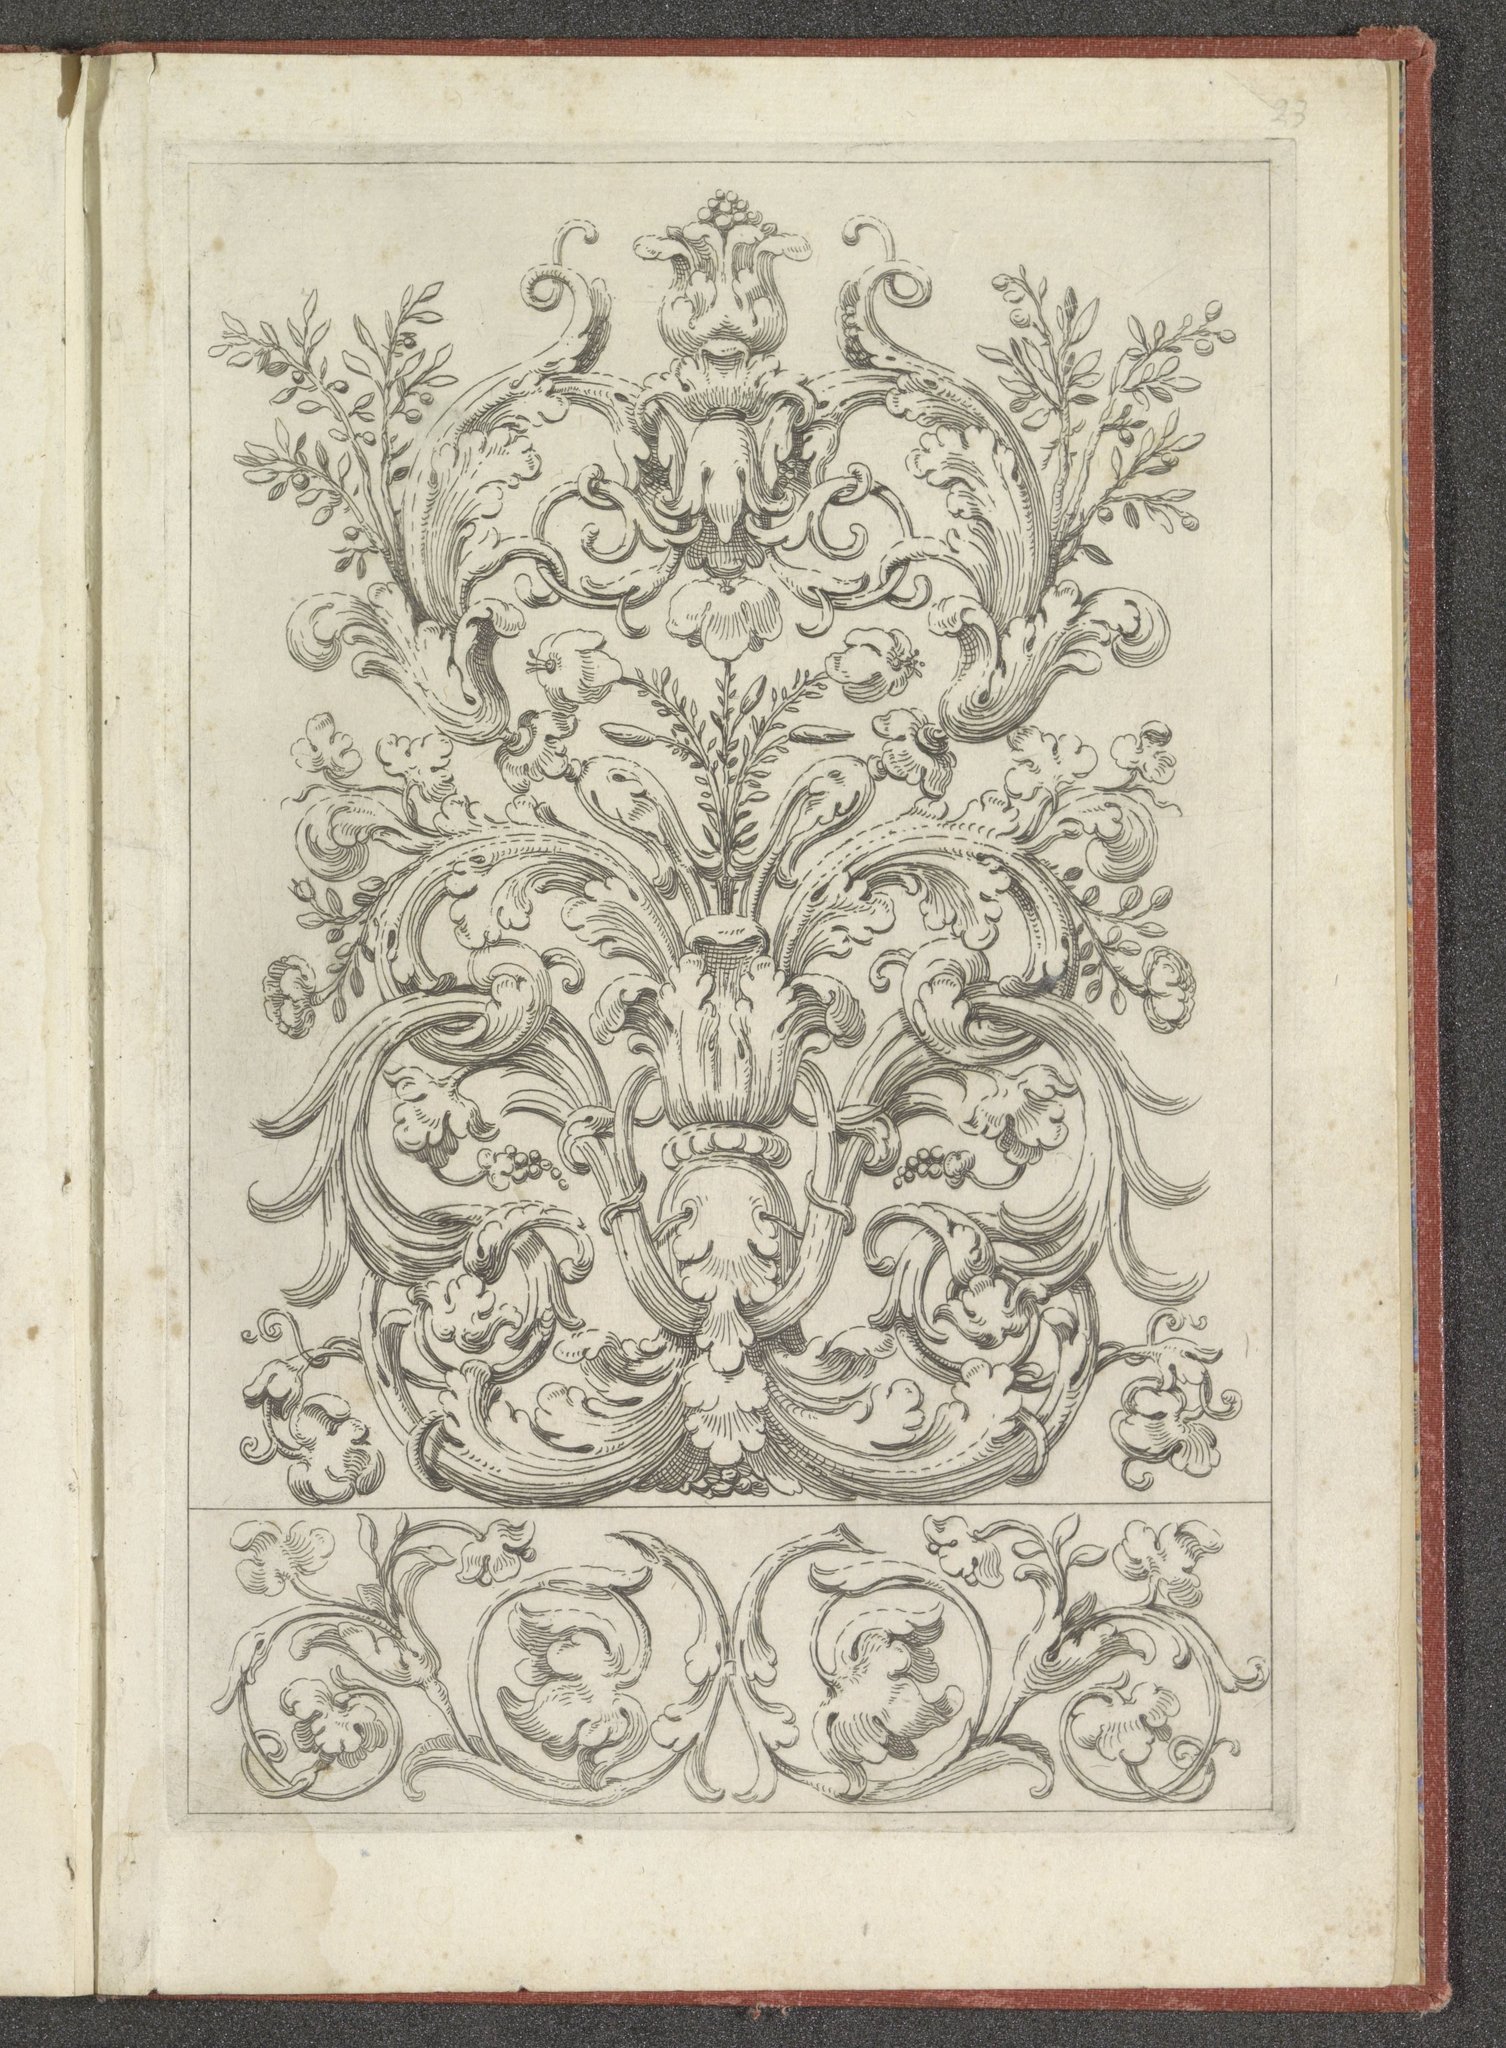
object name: album leaf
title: Rocailles en bloemen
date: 1636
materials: paper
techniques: etching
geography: rome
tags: rocaille ornament, foliage ~ ornament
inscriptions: collector's mark: Lugt 2760, collector's mark: Lugt 2228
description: Boven een ornament met rocailles, takken en bloemen. Onder een fries van krullende takken en bloemen. De prent maakt deel uit van een album.